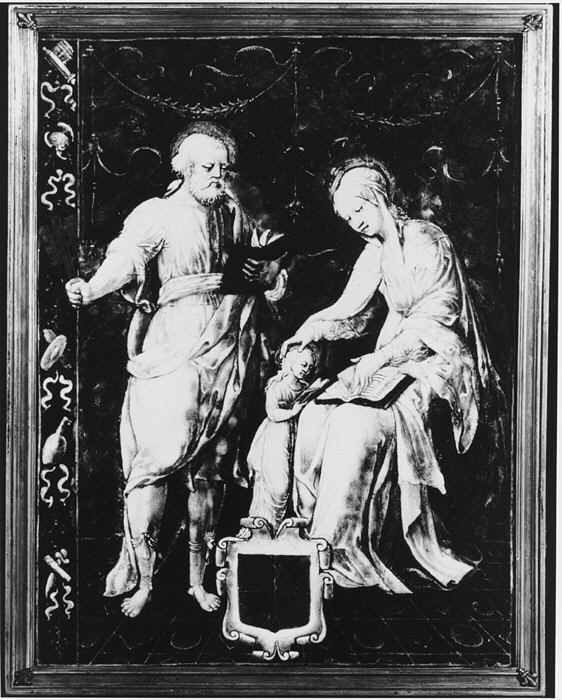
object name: plaque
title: The Education of the Virgin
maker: jean ii pénicaud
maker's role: enameler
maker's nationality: french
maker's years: 1524-1554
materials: copper, enamel, gilt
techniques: painting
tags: reading,virgin mary